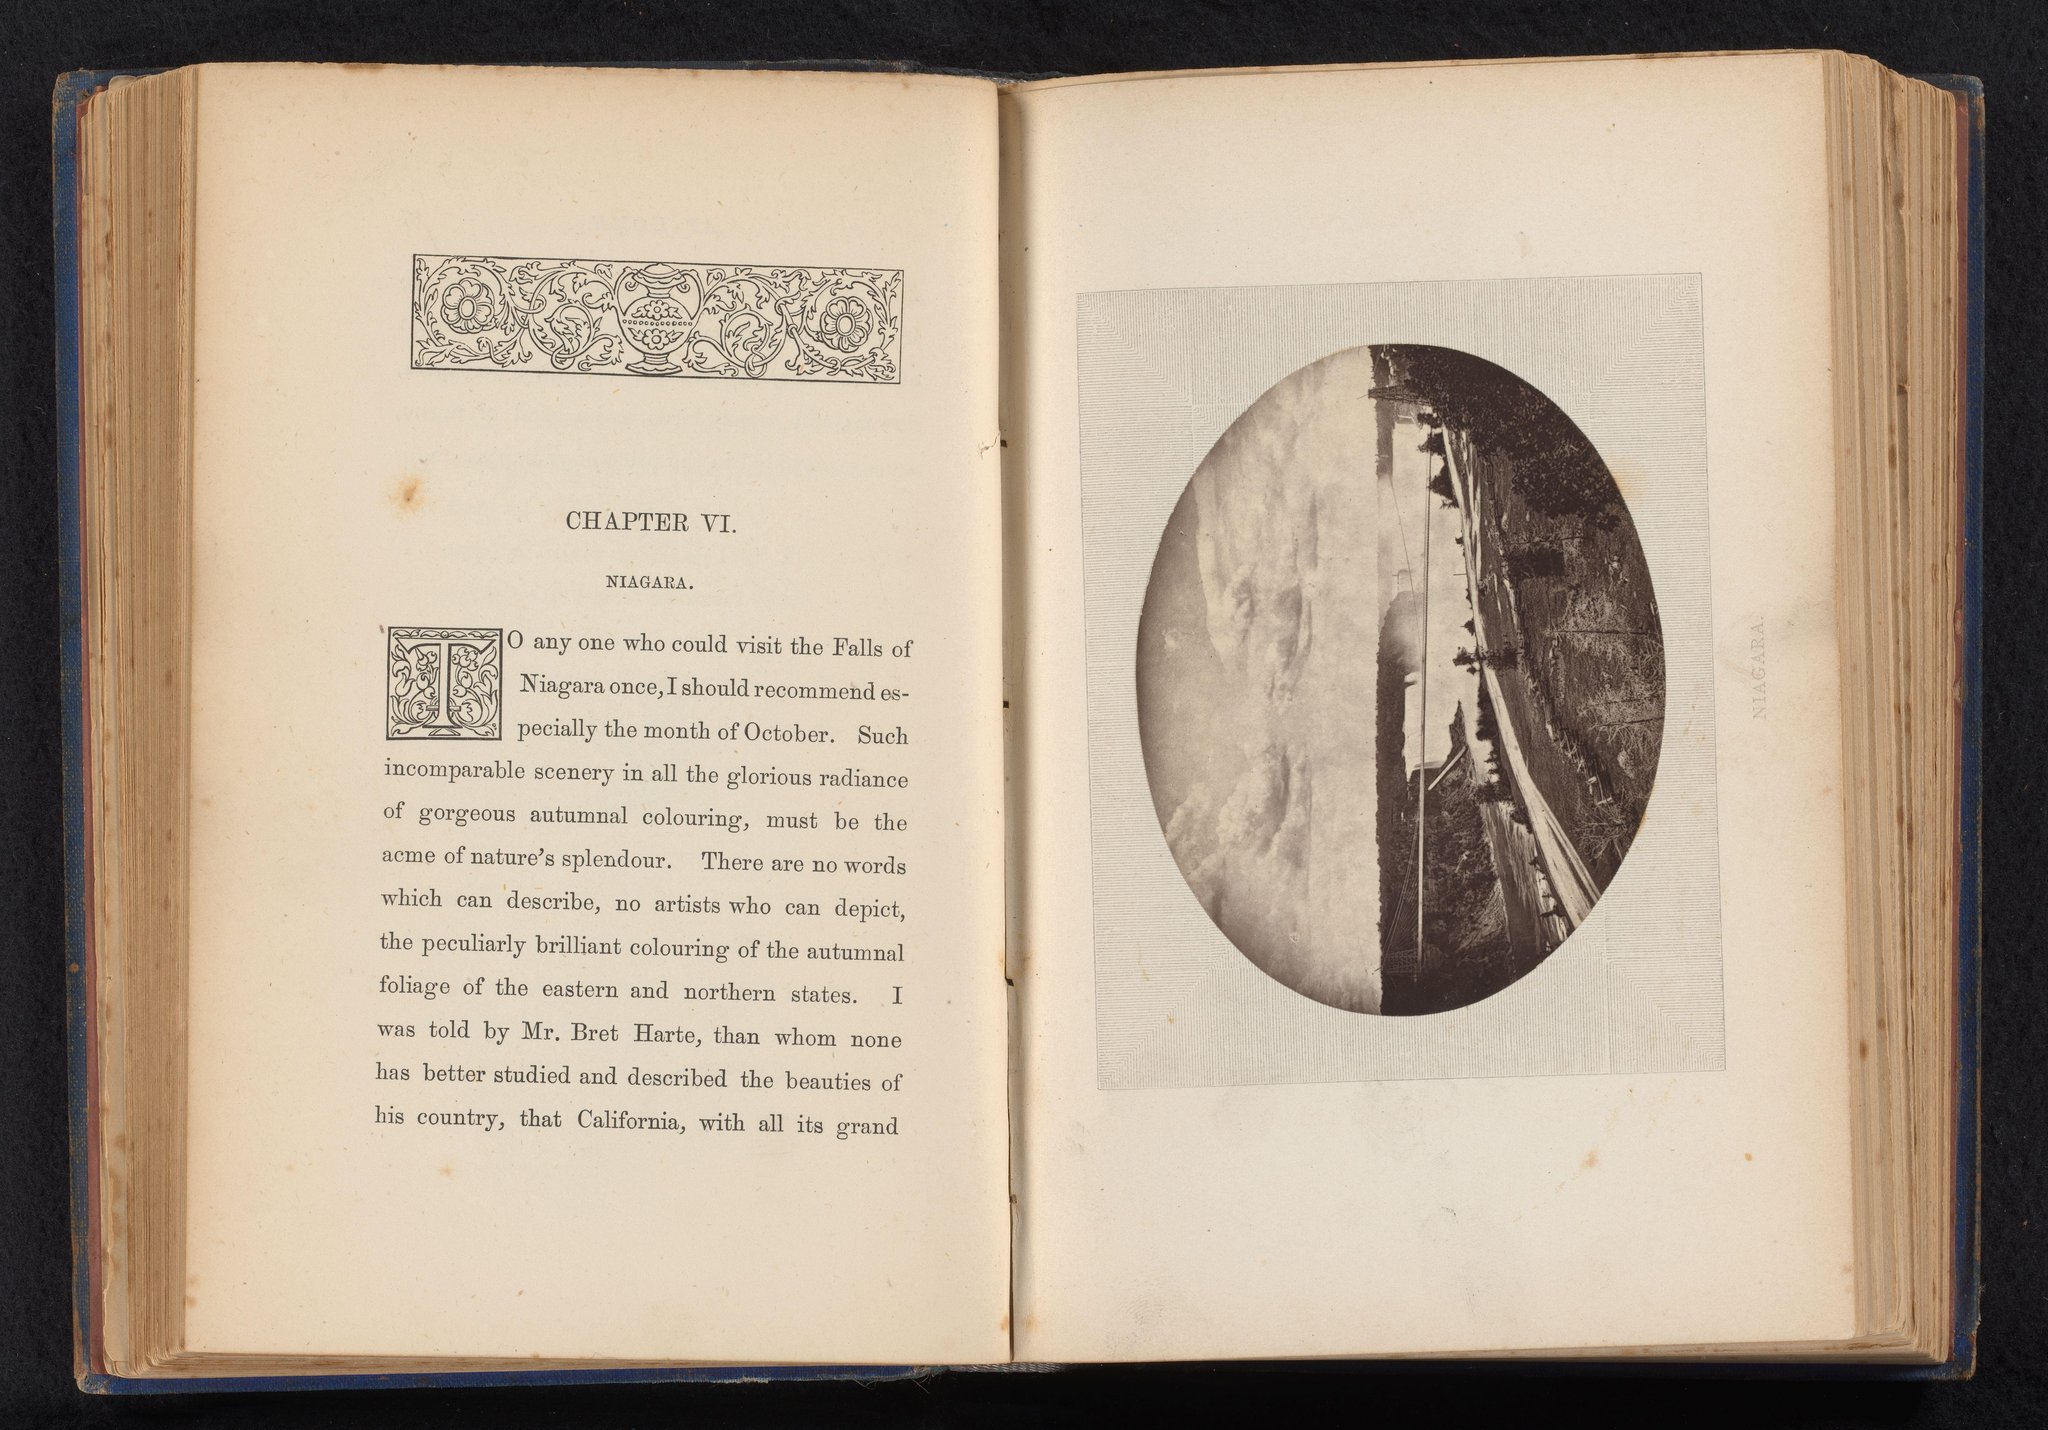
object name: page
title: Gezicht op de Niagarawatervallen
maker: Anonymous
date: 1862-1872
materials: paper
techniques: albumen print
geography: niagara falls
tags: waterfall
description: Foto op tweede ongenummerde pagina voor pagina 89.